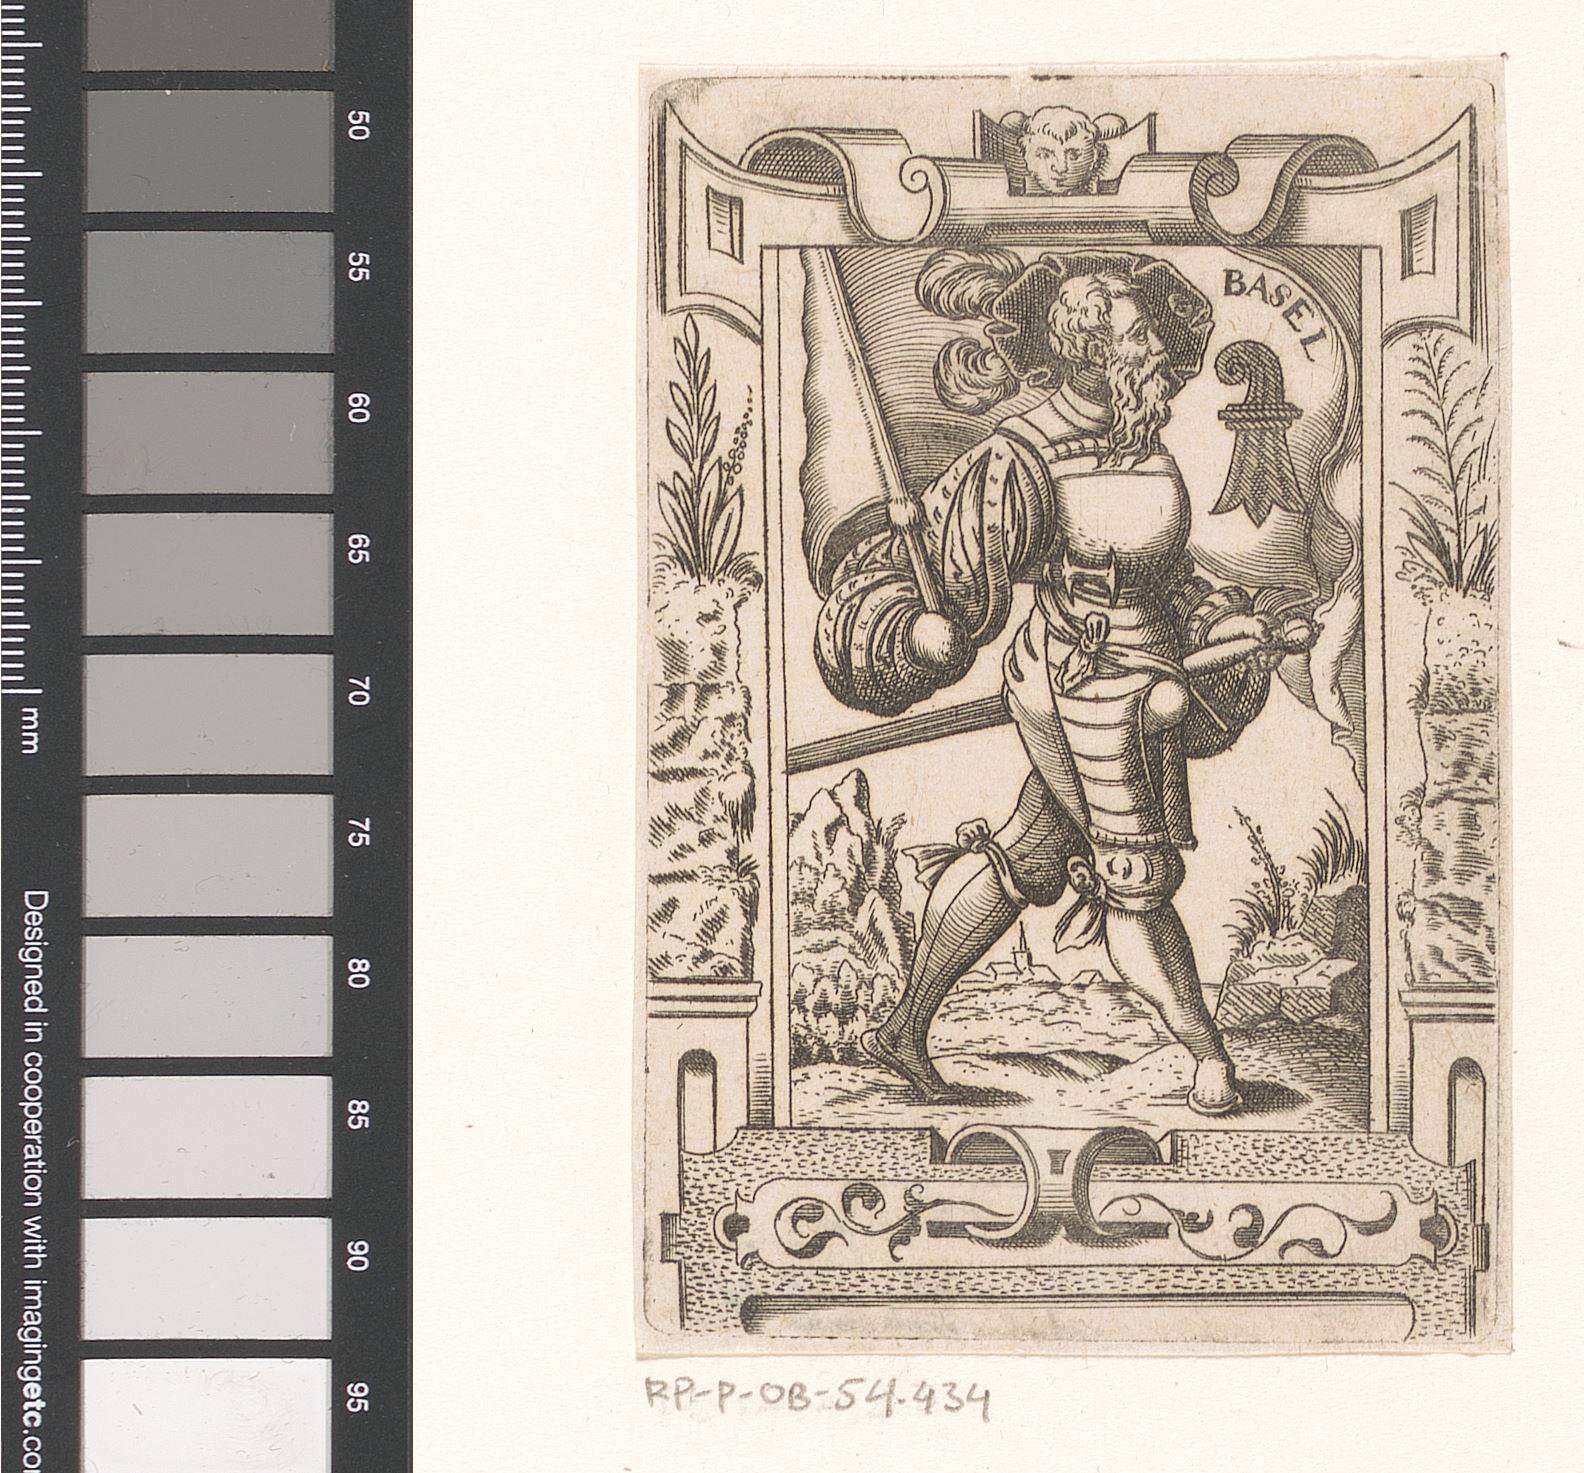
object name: print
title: Basel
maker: virgilius solis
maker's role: draughtsman, print maker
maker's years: 1514-1562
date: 1524-1562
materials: paper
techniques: engraving, etching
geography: nuremberg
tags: scrollwork, strapwork ~ ornament, (military) standard-bearer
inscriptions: number: ‘145’, collector's mark: Lugt 2228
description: Prent maakt deel uit van een serie van veertien prenten met voorstellingen van vaandeldragers met vaandels van de Zwitserse kantons.